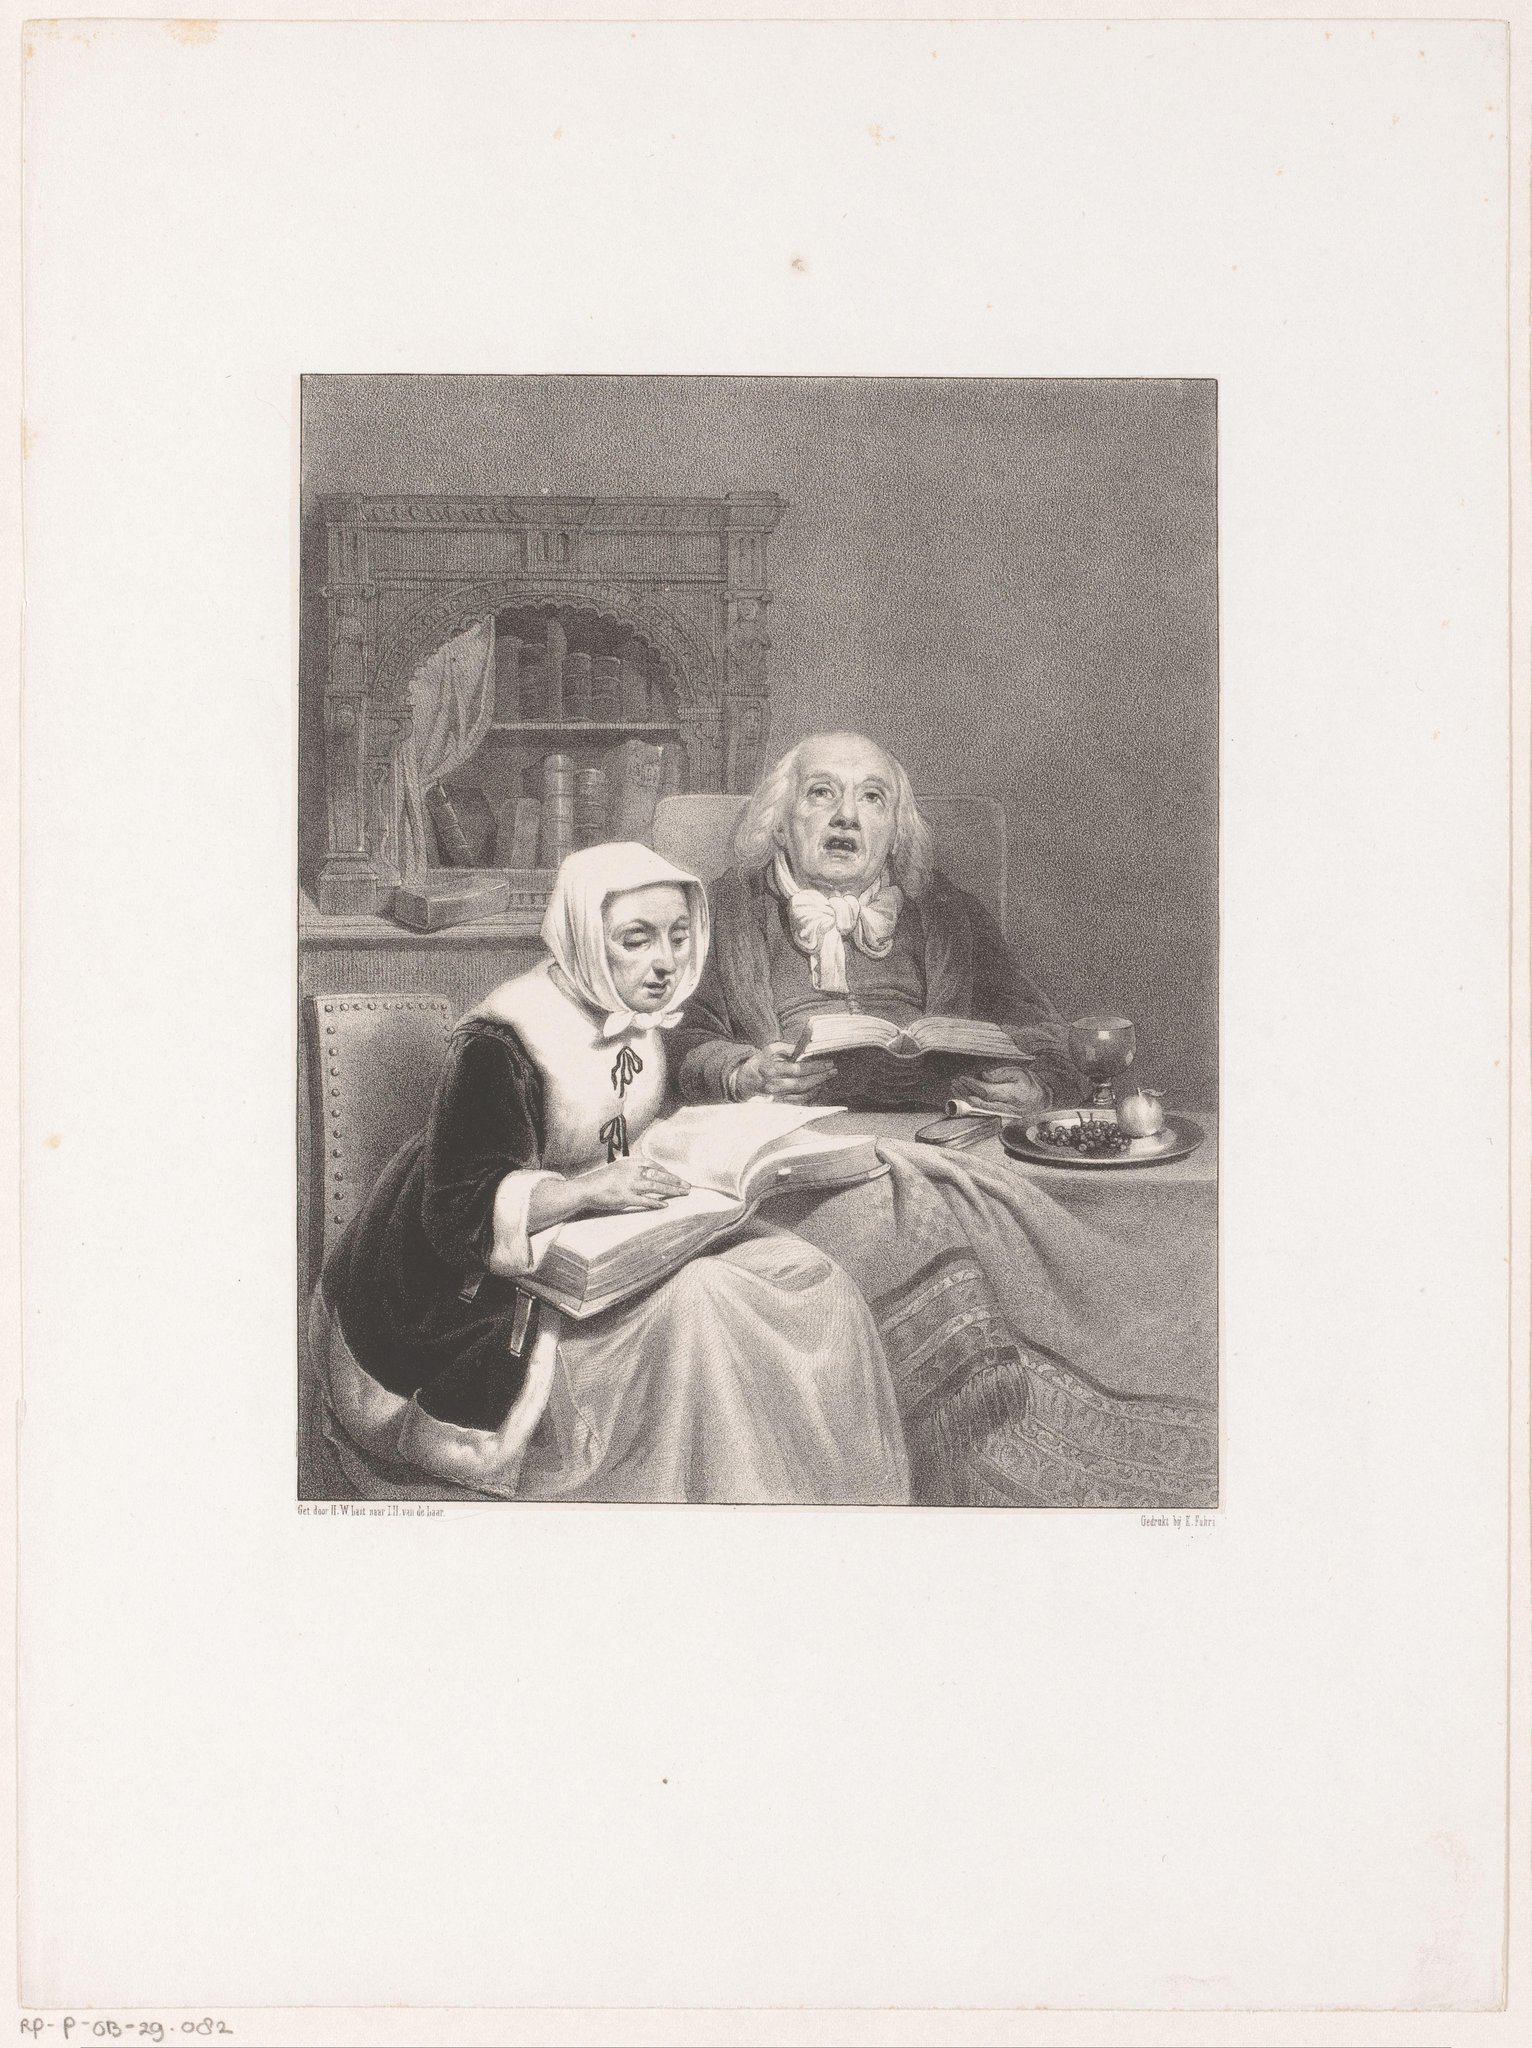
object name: print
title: Zingend paar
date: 1837-1853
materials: paper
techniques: lithograph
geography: the hague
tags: bookshelves, reading, vocal music, singing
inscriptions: collector's mark: Lugt 2228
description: De oude man kijkt naar boven, de vrouw leest uit het boek. Achter hen een boekenkast.